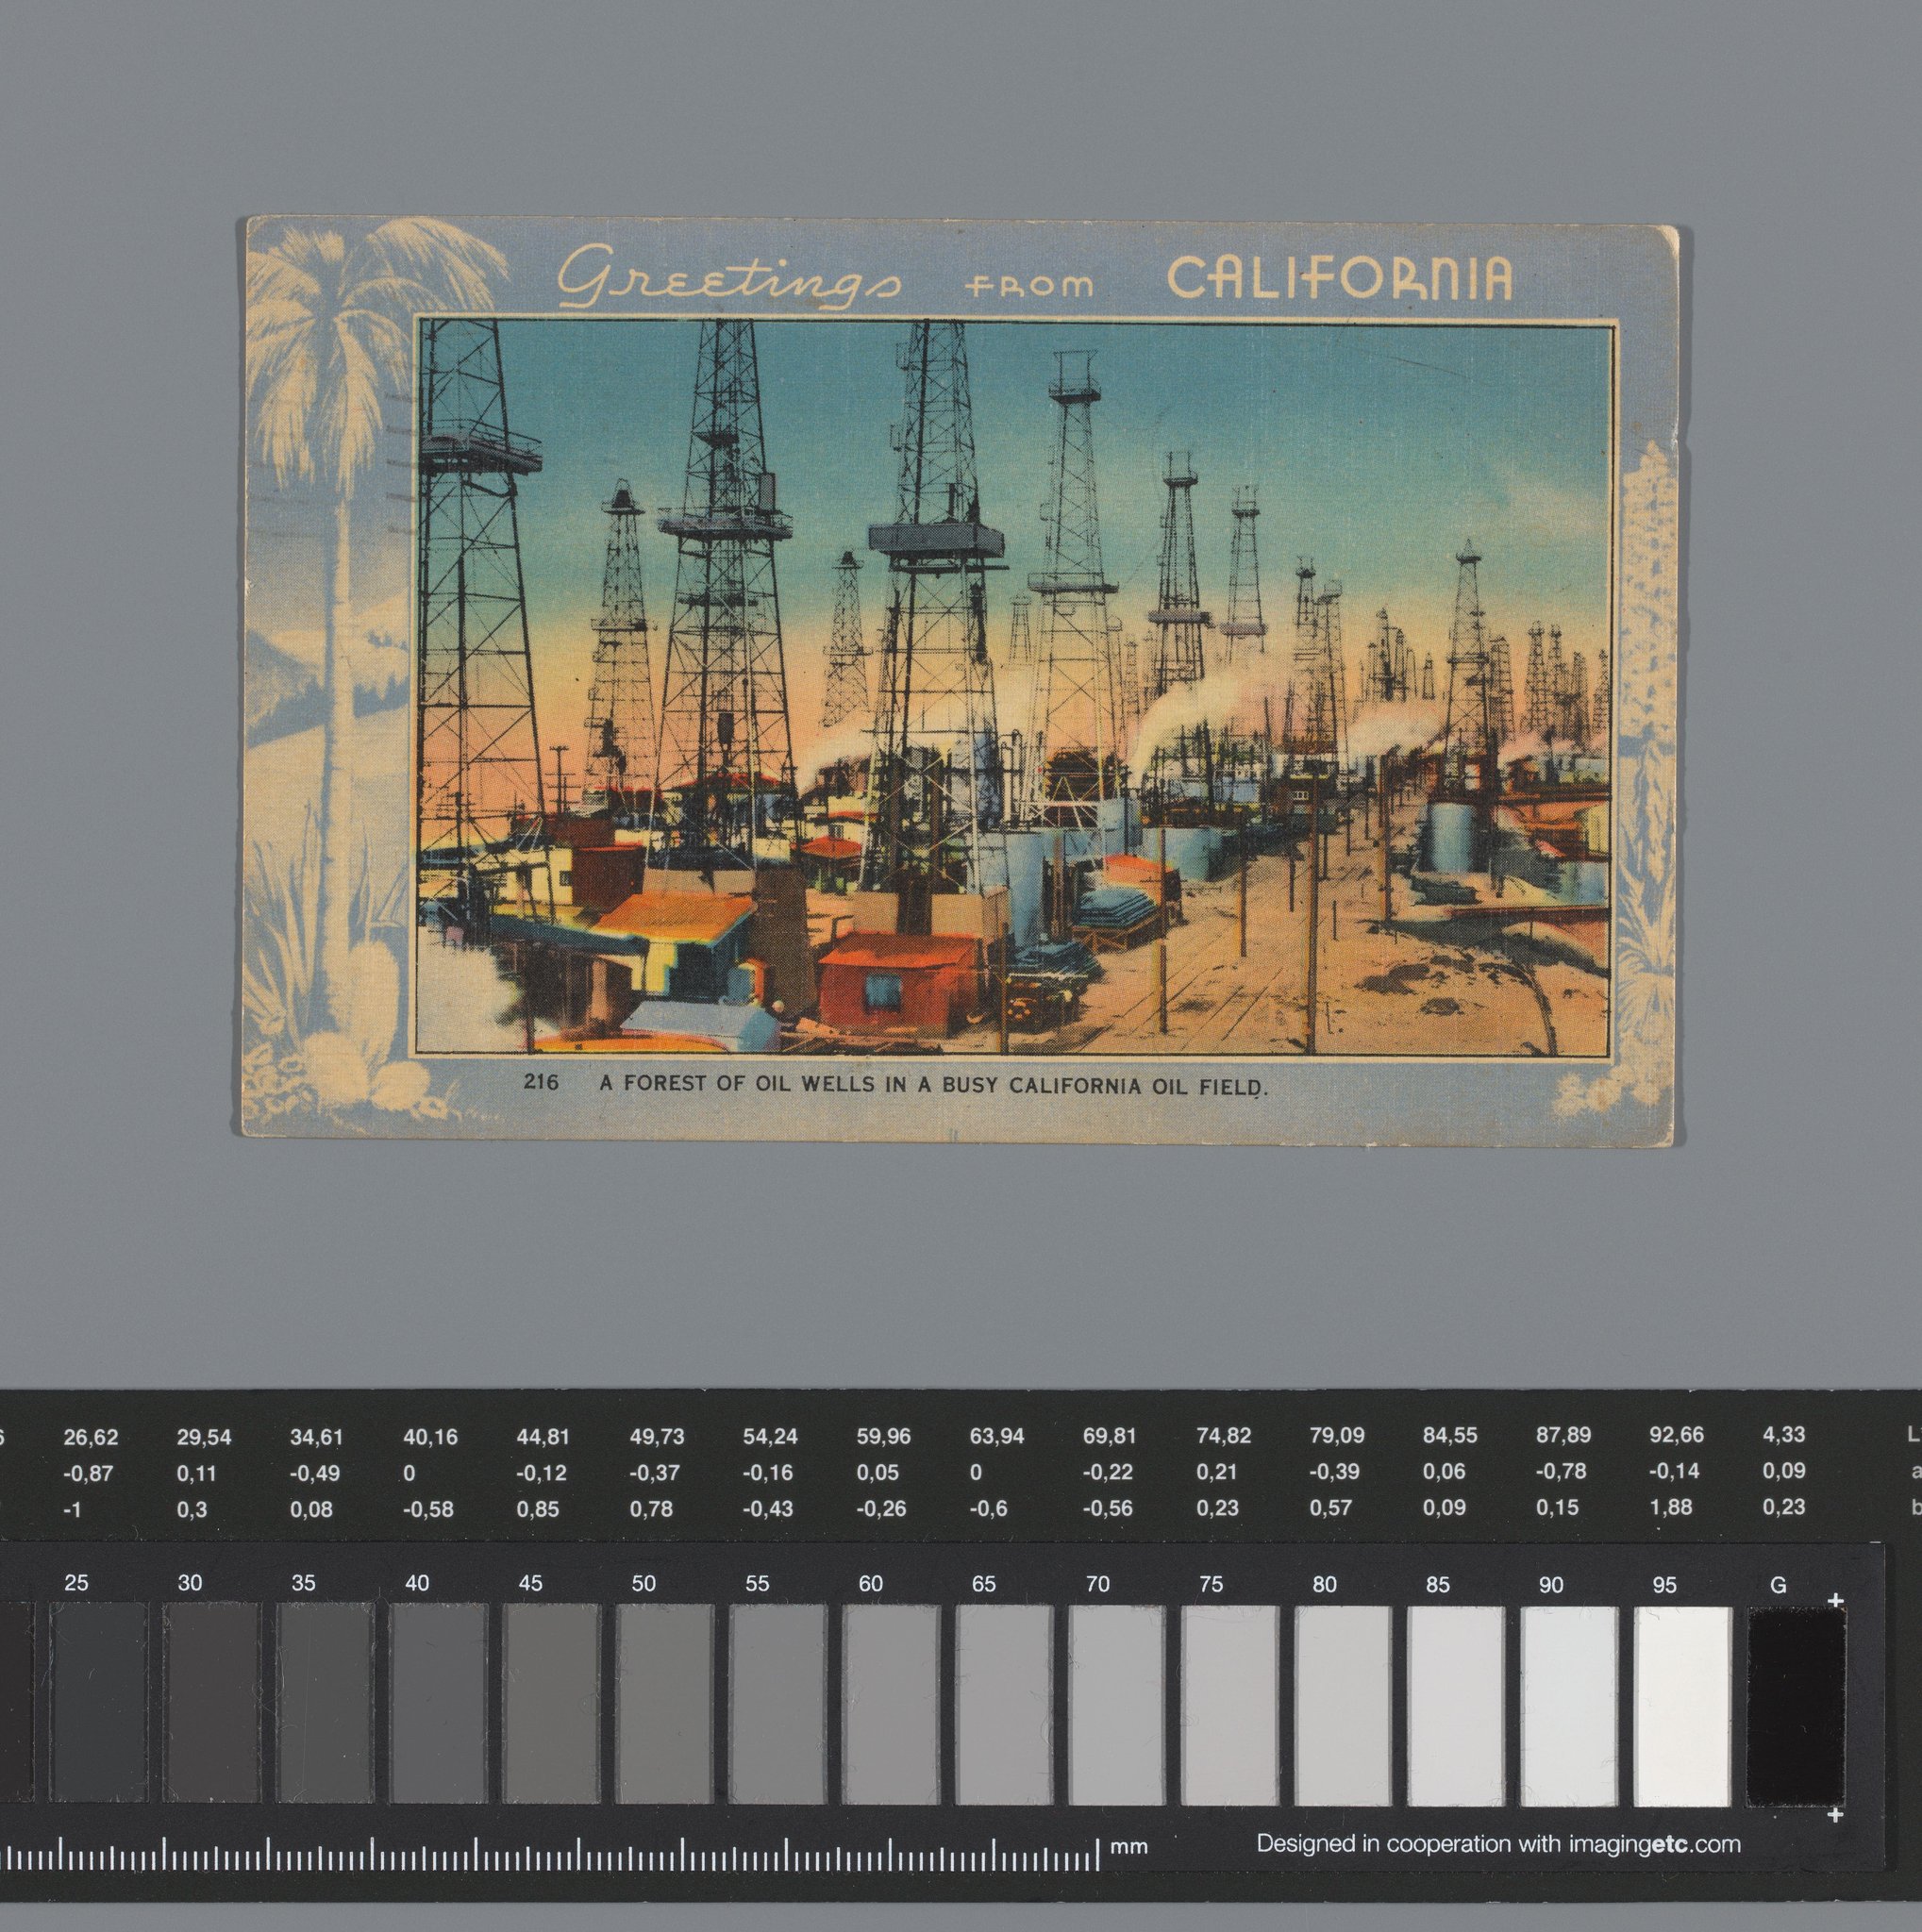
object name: ansichtkaart, prentbriefkaart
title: Olieveld met boortorens, Californië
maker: Anonymous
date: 1940-1944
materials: paper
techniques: autotype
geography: los angeles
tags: californië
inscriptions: inscription: ‘Greetings FROM CALIFORNIA’, inscription: ‘216 A FOREST OF OIL WELLS IN A BUSY CALIFORNIA OIL FIELD’, inscription: ‘Gardner-Thompson Co., Los Angeles, California // California Scenic Views’, stamp: ‘ORANGE / MAR 21 / 1944 / 230PM / CALIF.’